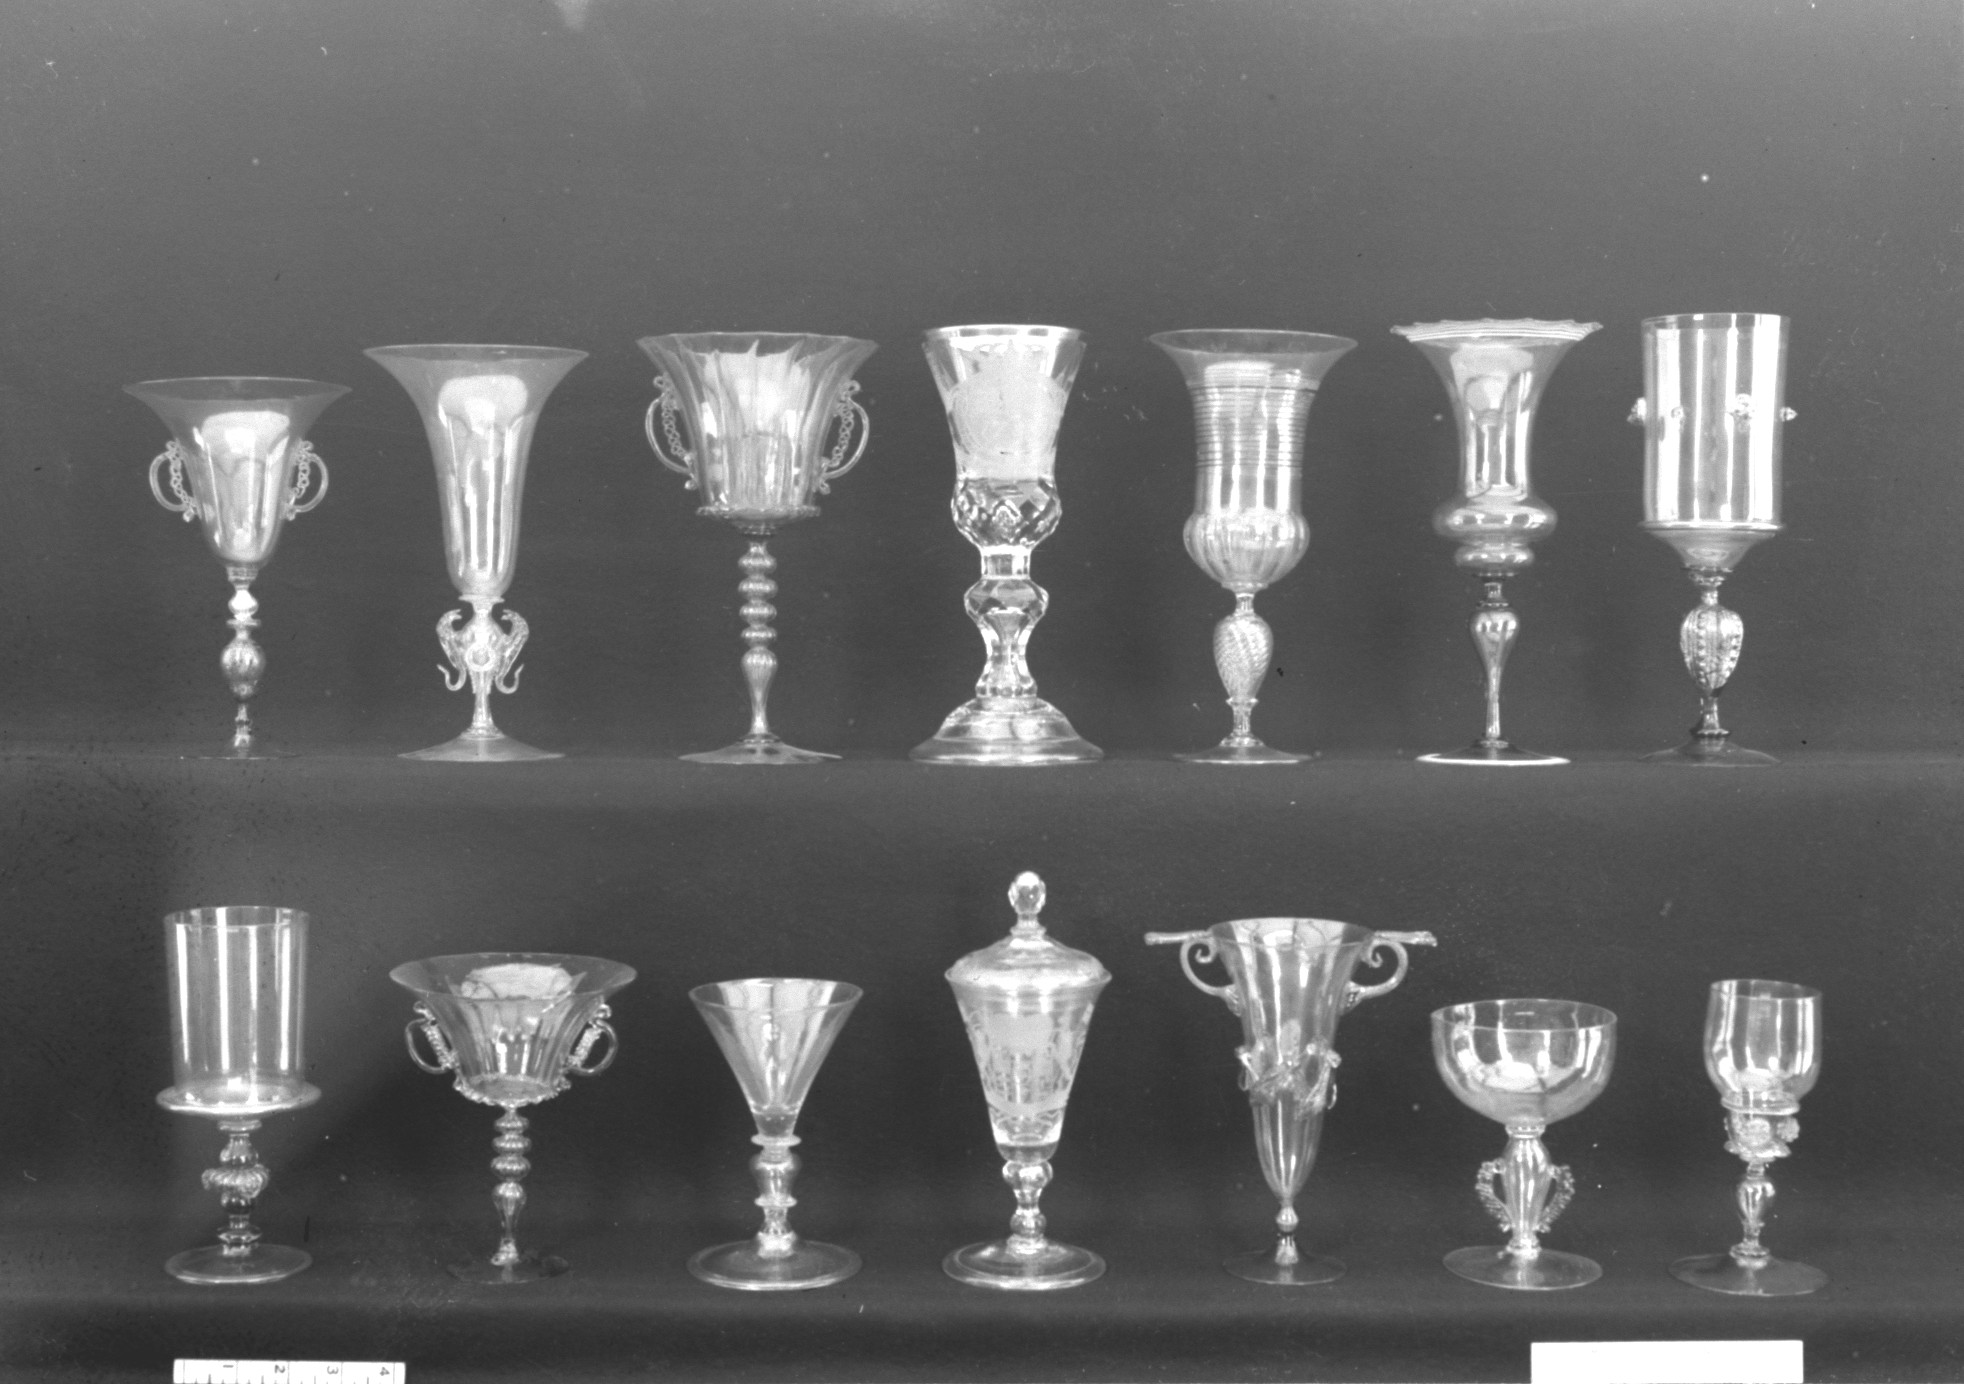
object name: goblet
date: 1601-1800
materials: glass